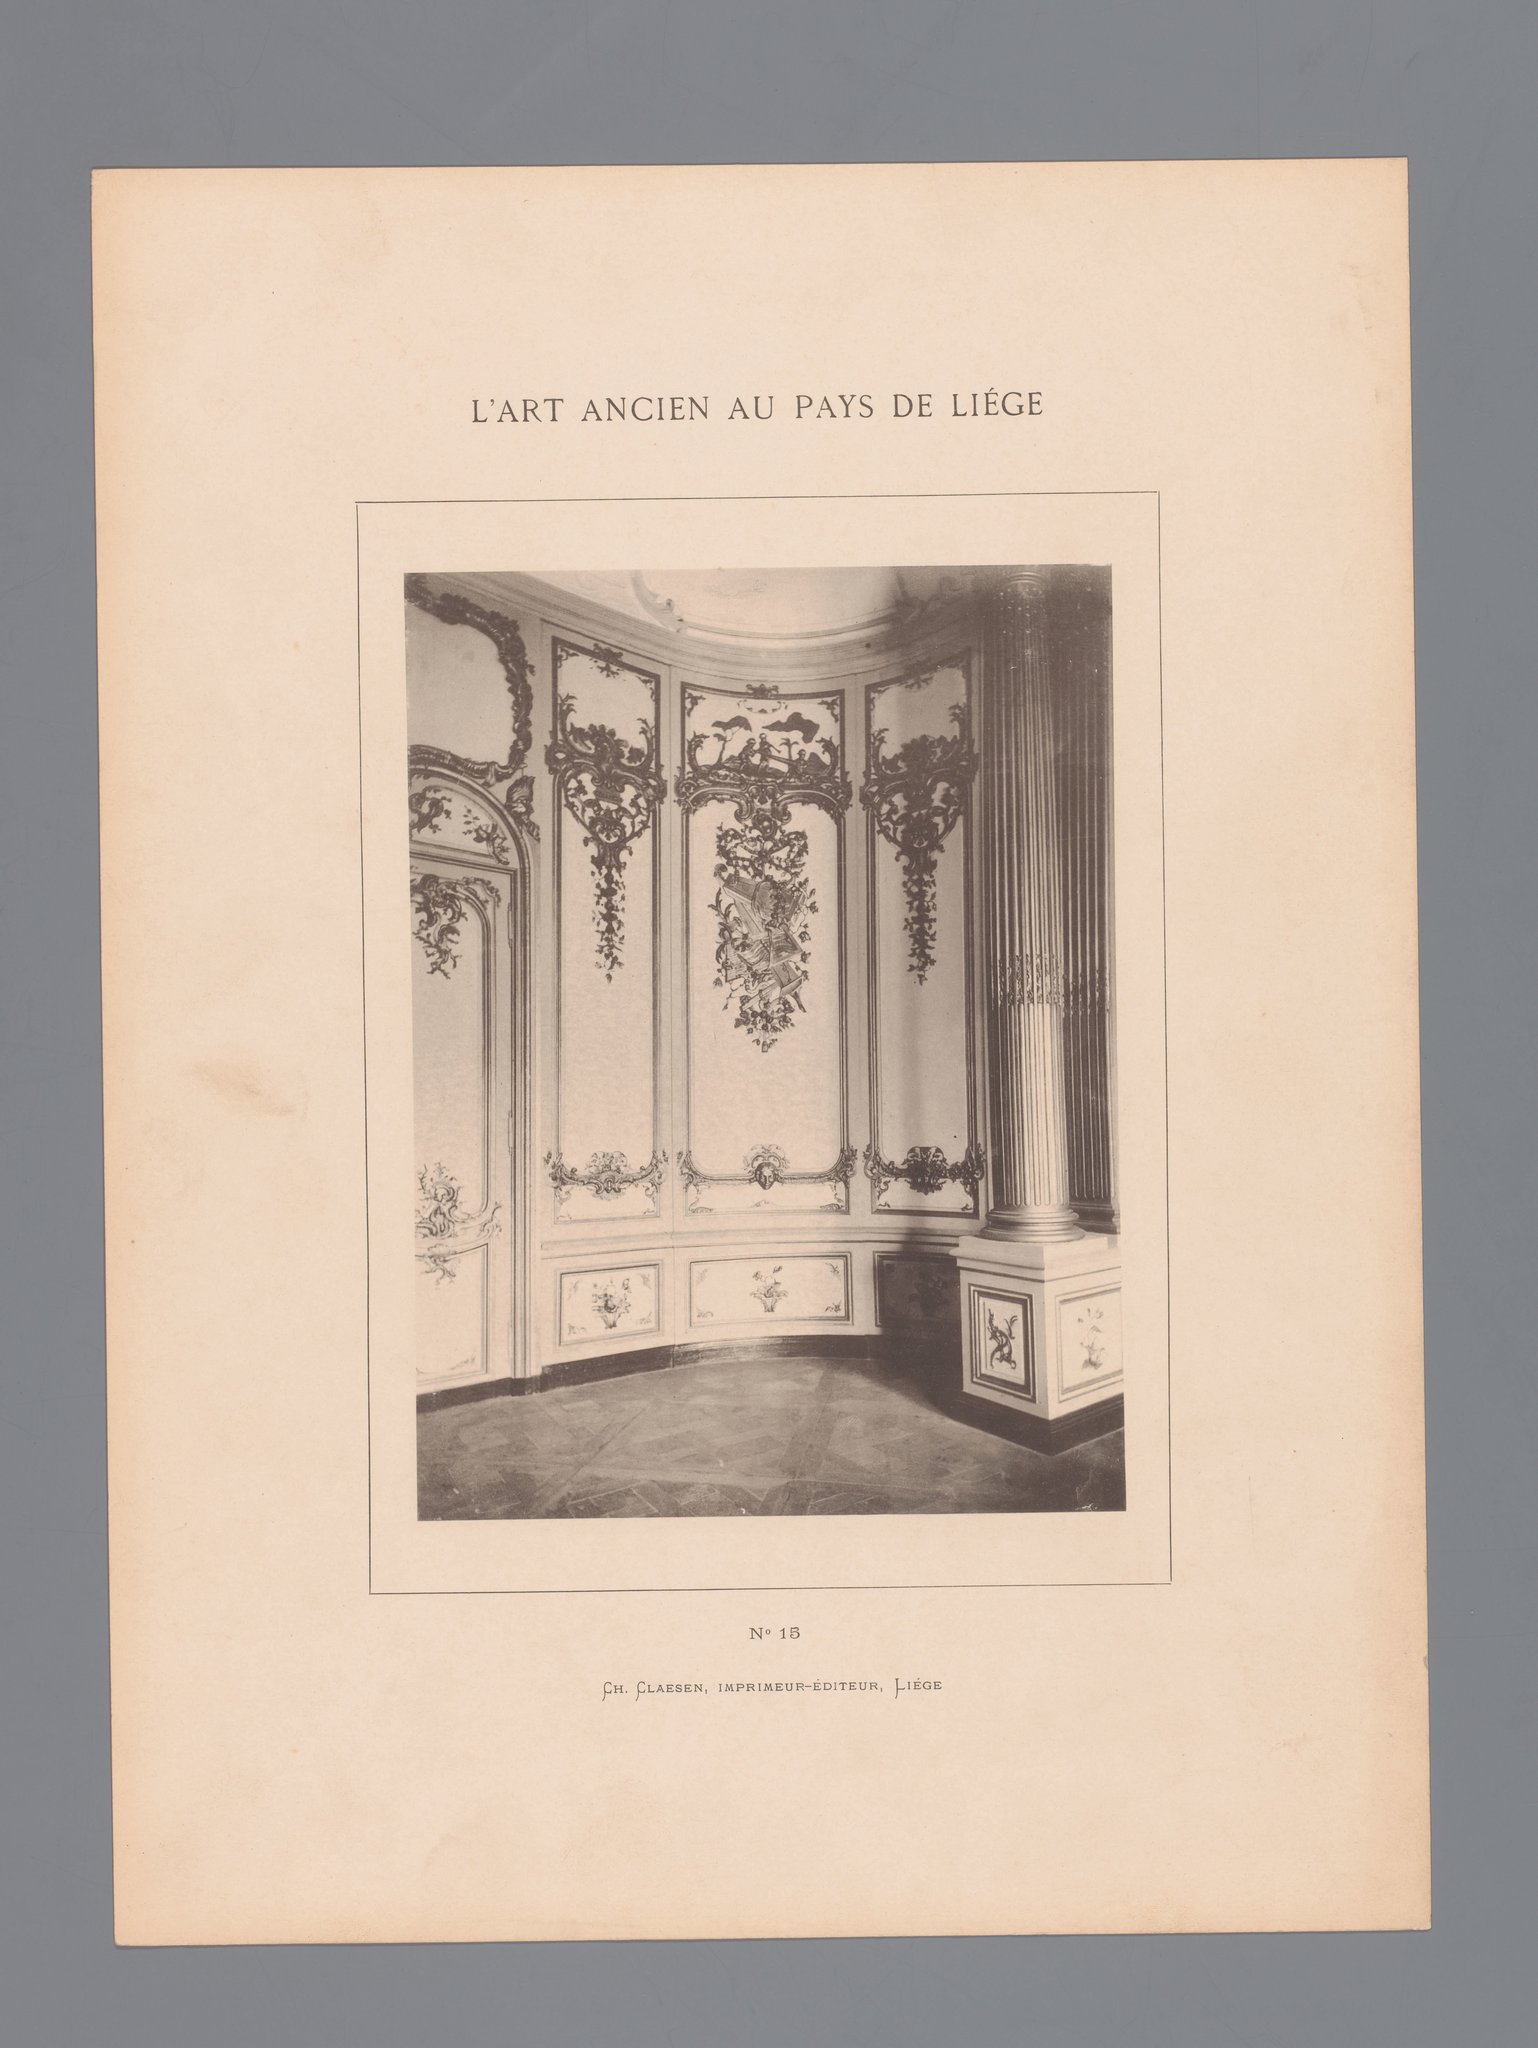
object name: photomechanical print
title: Kamer met zuil in de oude prefectuur in Luik, België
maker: Anonymous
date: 1879-1884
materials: paper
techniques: photograph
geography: liège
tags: column, pillar ~ architecture, interior of the house, liège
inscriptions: number: ‘No 15’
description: Deze prent maakt deel uit van een omslag met twintig prenten, een titelblad en een lijst van afbeeldingen.